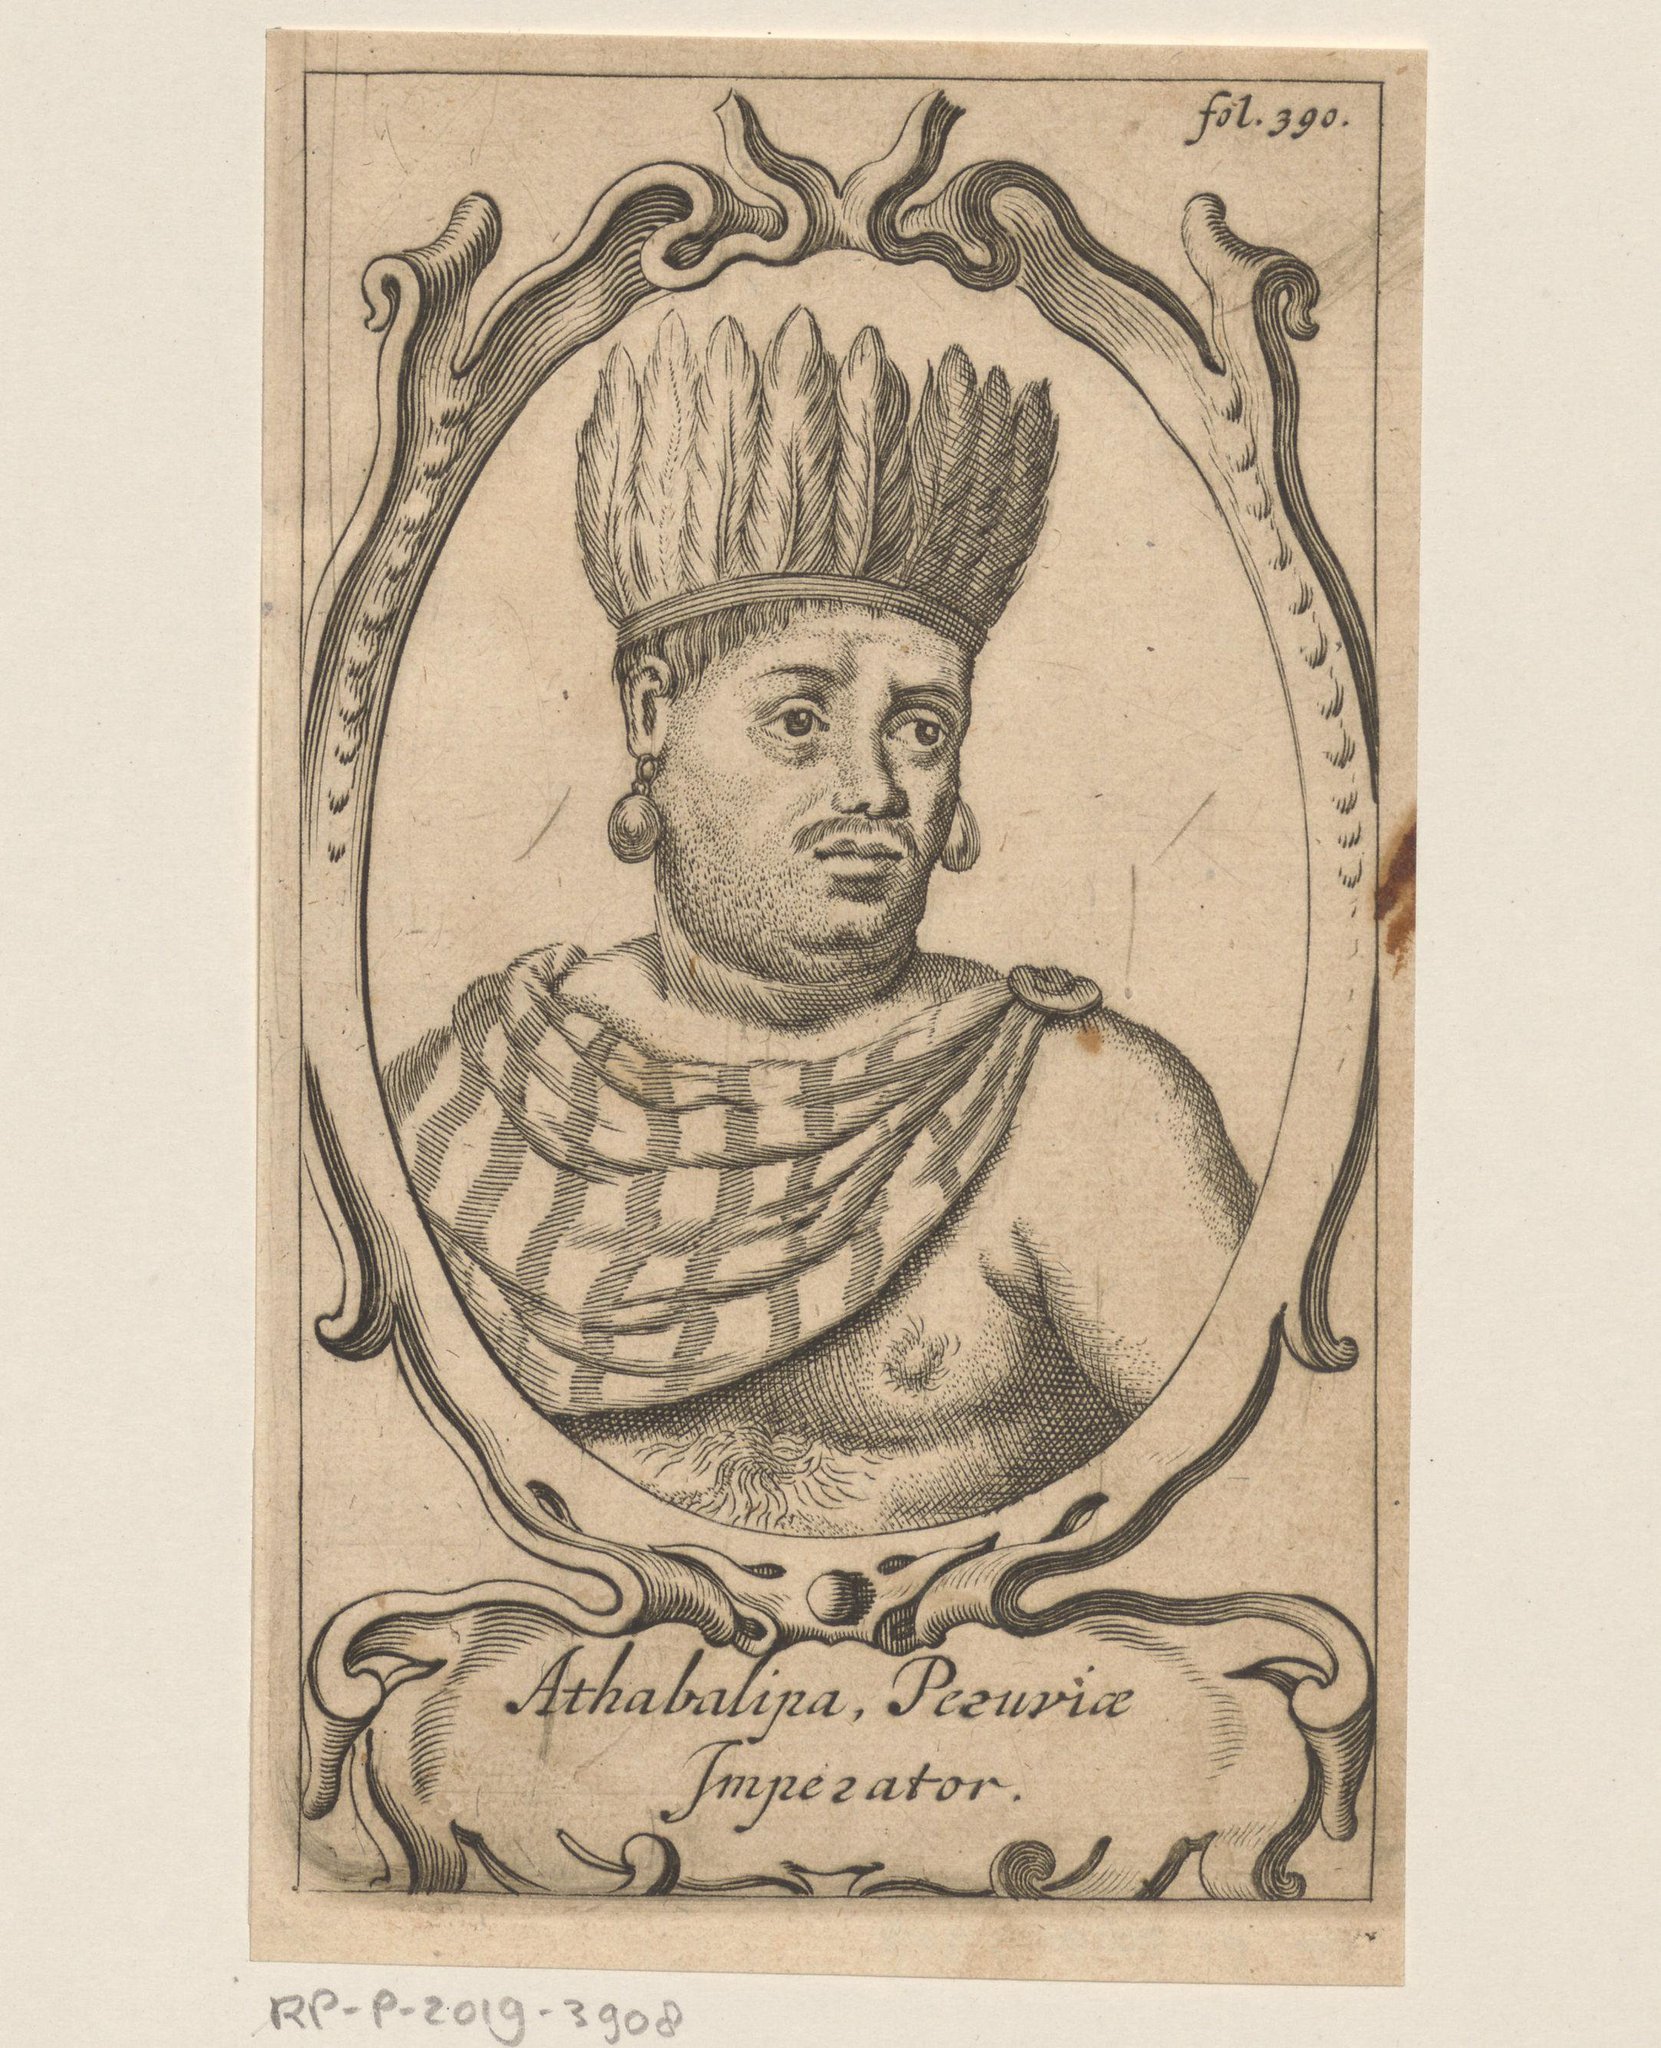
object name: print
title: Portret van Atahualpa, keizer van het Incarijk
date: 1660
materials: paper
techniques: engraving, etching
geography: amsterdam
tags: historical persons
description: Prent uit: Bos, Lambert van den. Het vorstelick treur-toonneel, of op- en onder-gangh der grooten (...). Amsterdam: Abraham Wolfgang, 1660, p. 390.